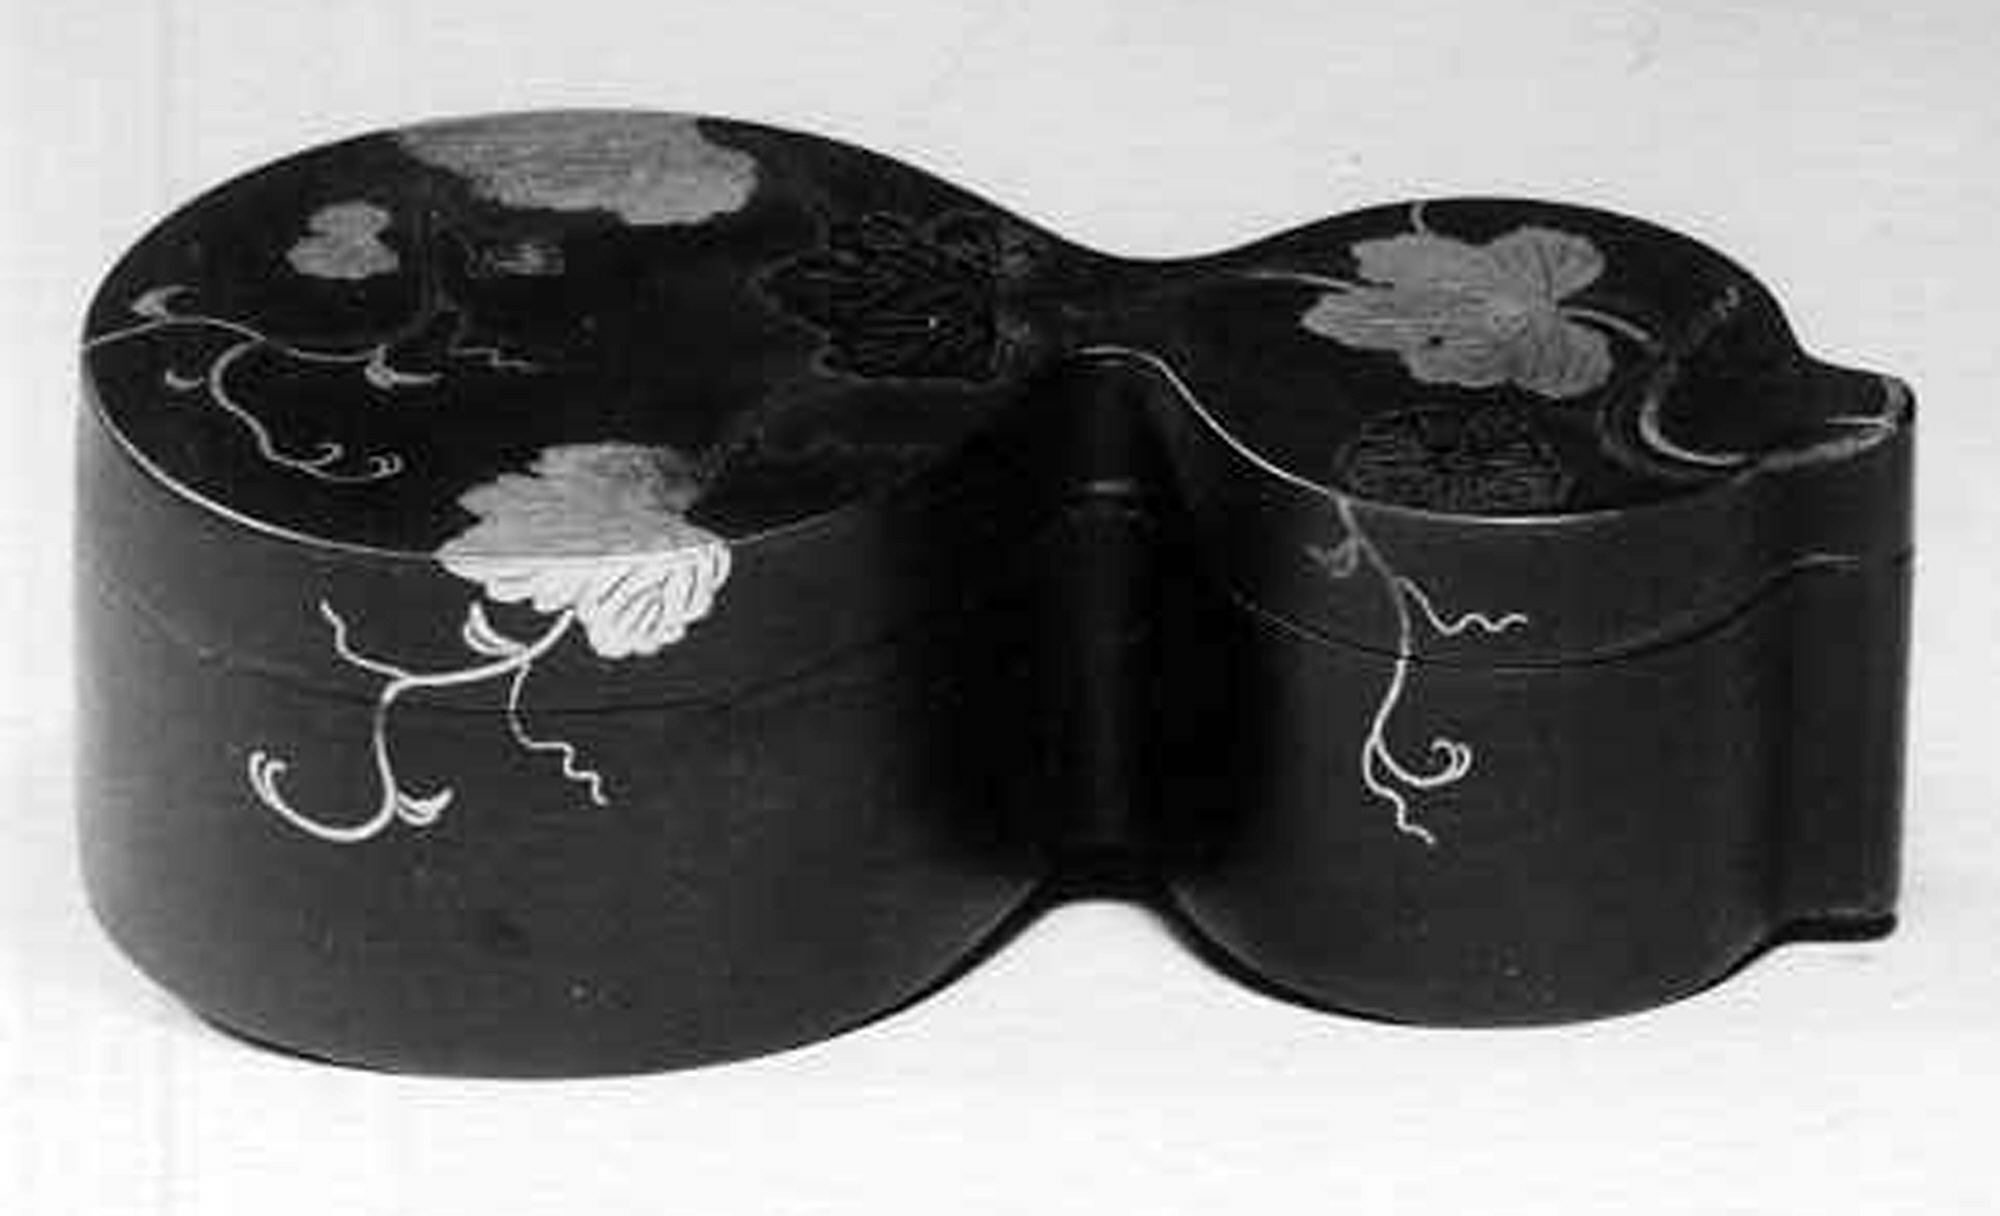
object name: incense box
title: Gourd-shaped Incense Box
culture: japanese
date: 1701-1800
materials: gold, iron, silver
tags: leaves